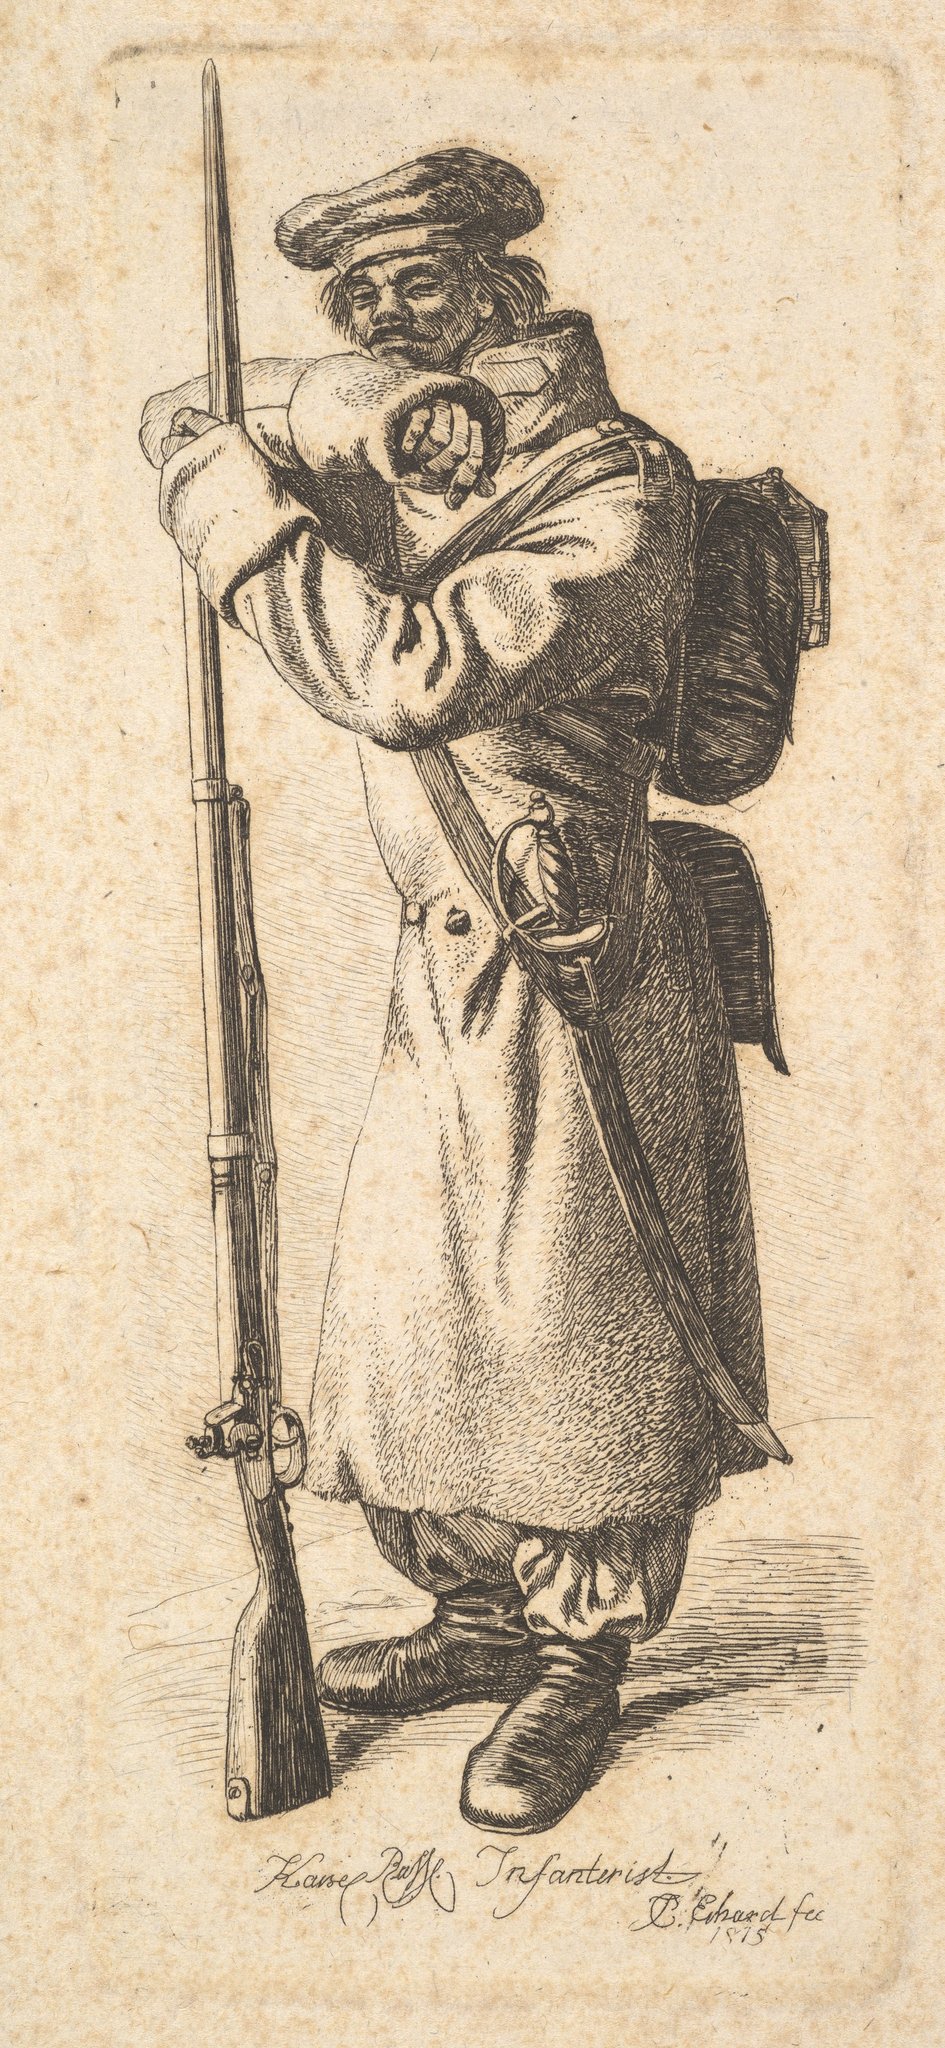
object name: print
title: The Russian Infantryman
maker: johann christoph erhard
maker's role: artist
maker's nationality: german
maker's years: 1795-1822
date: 1815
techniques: etching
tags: soldiers,firearms